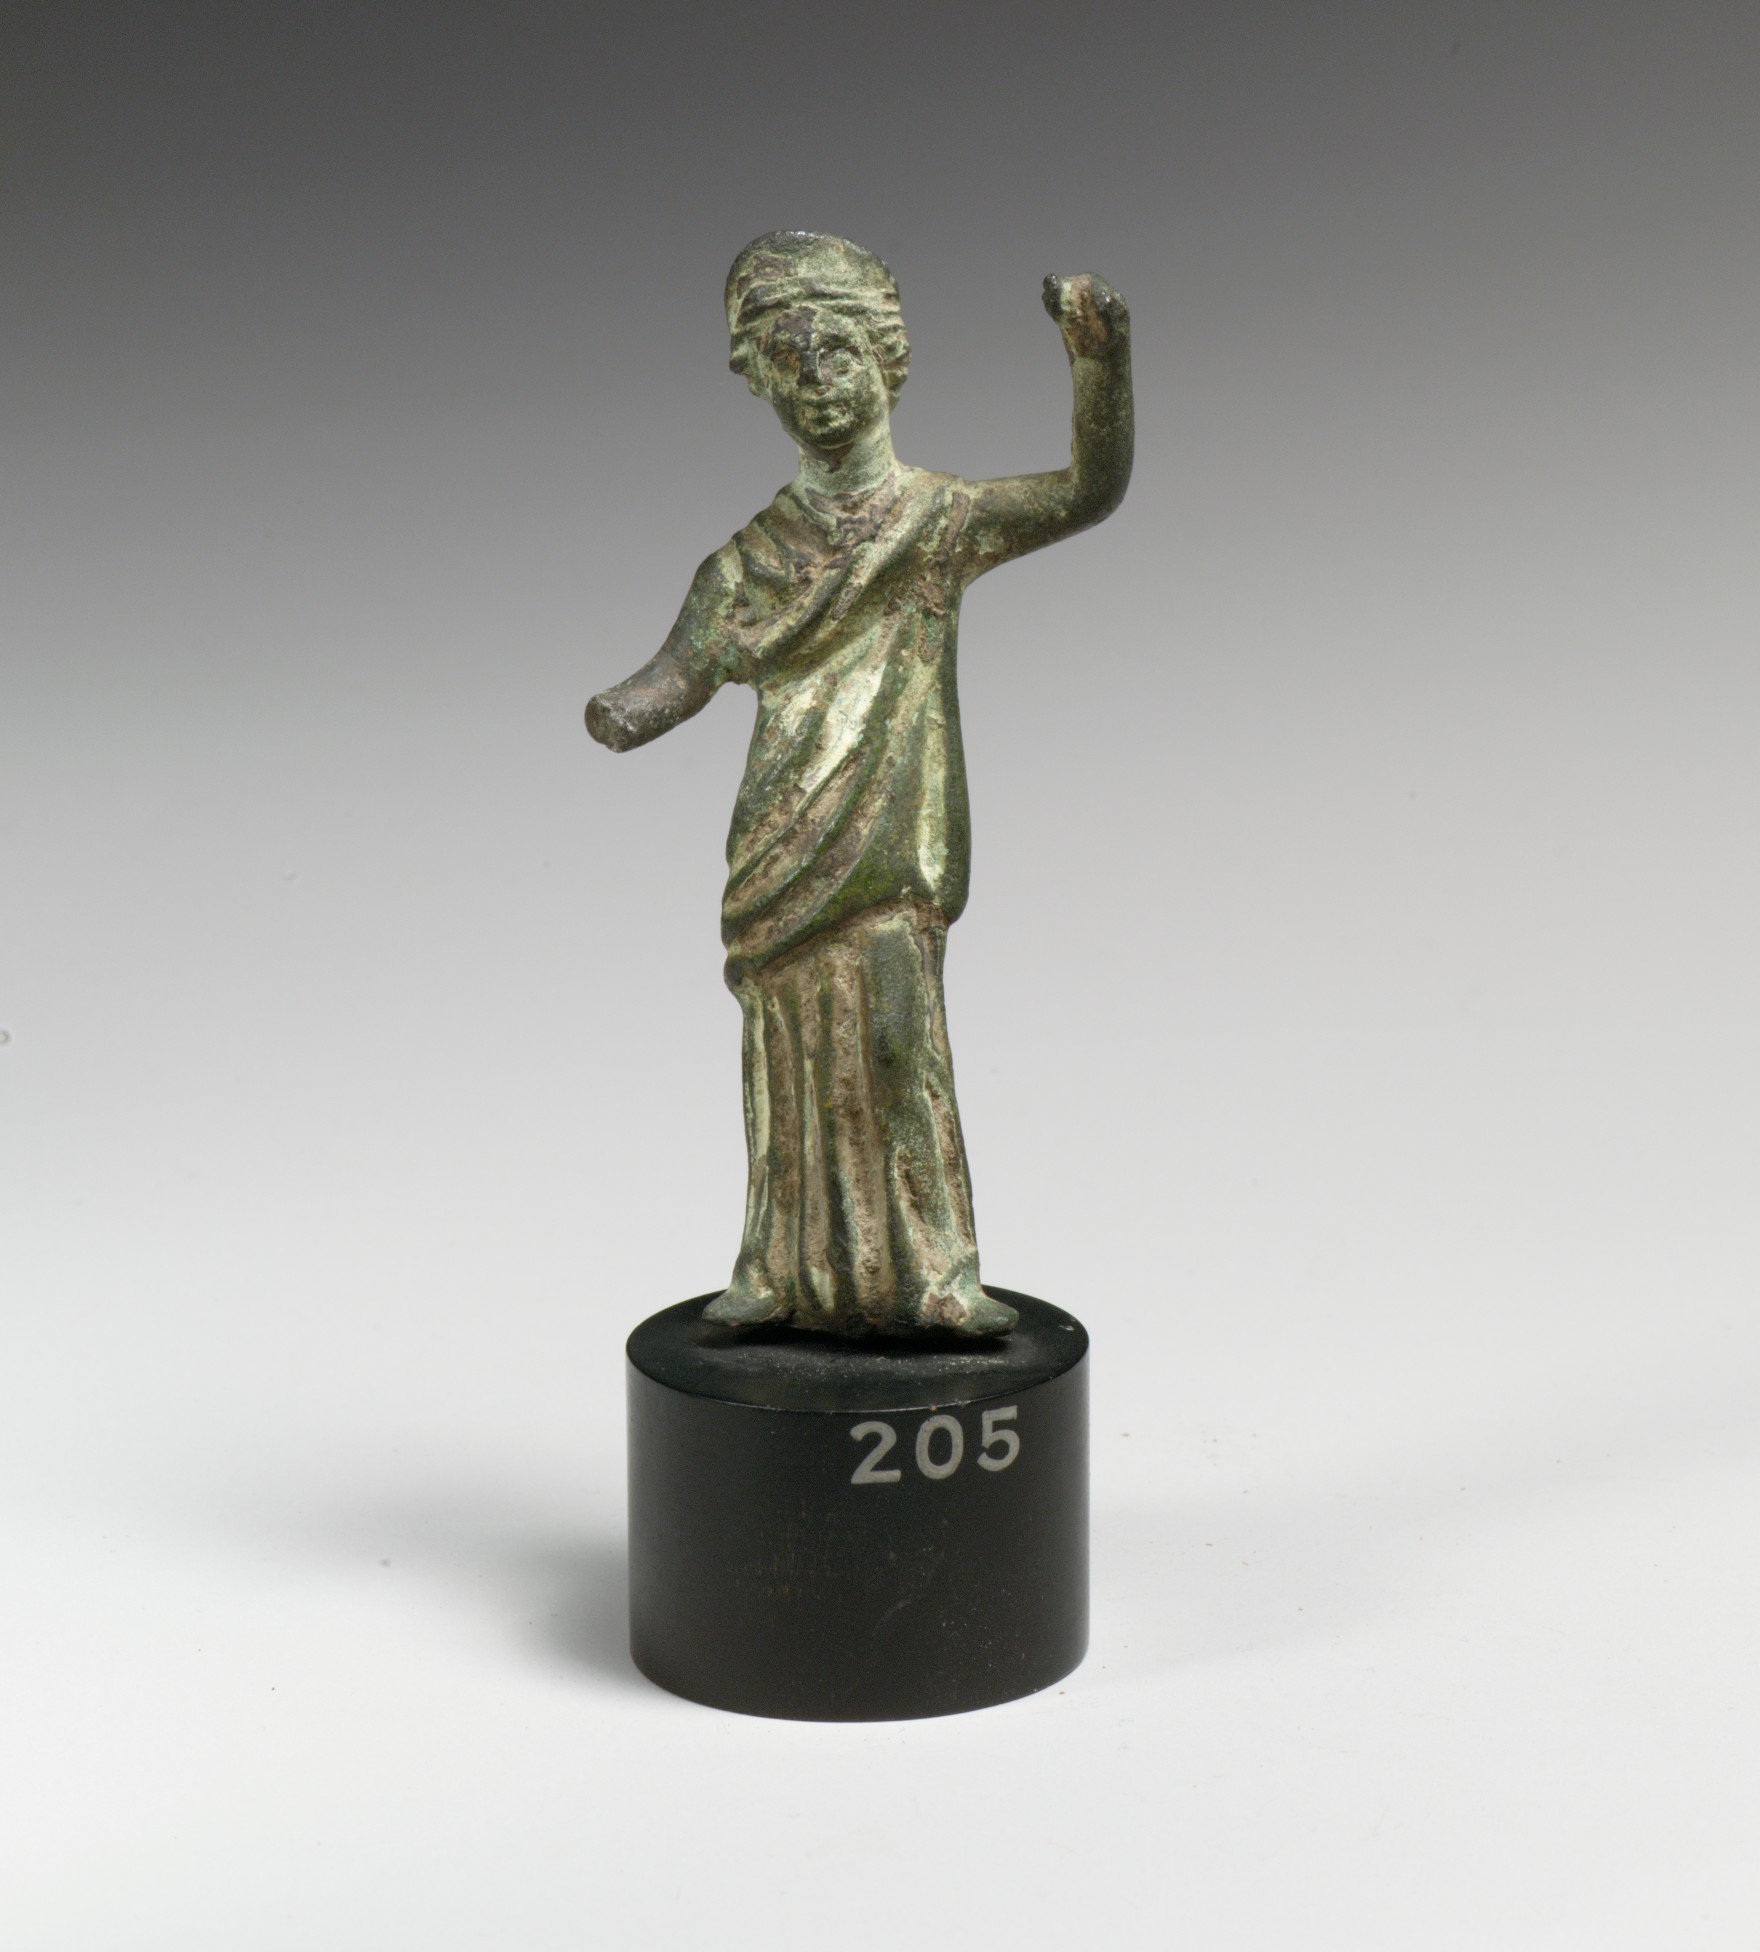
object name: statuette of a seated goddess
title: Bronze statuette of a goddess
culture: roman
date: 1-200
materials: bronze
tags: juno